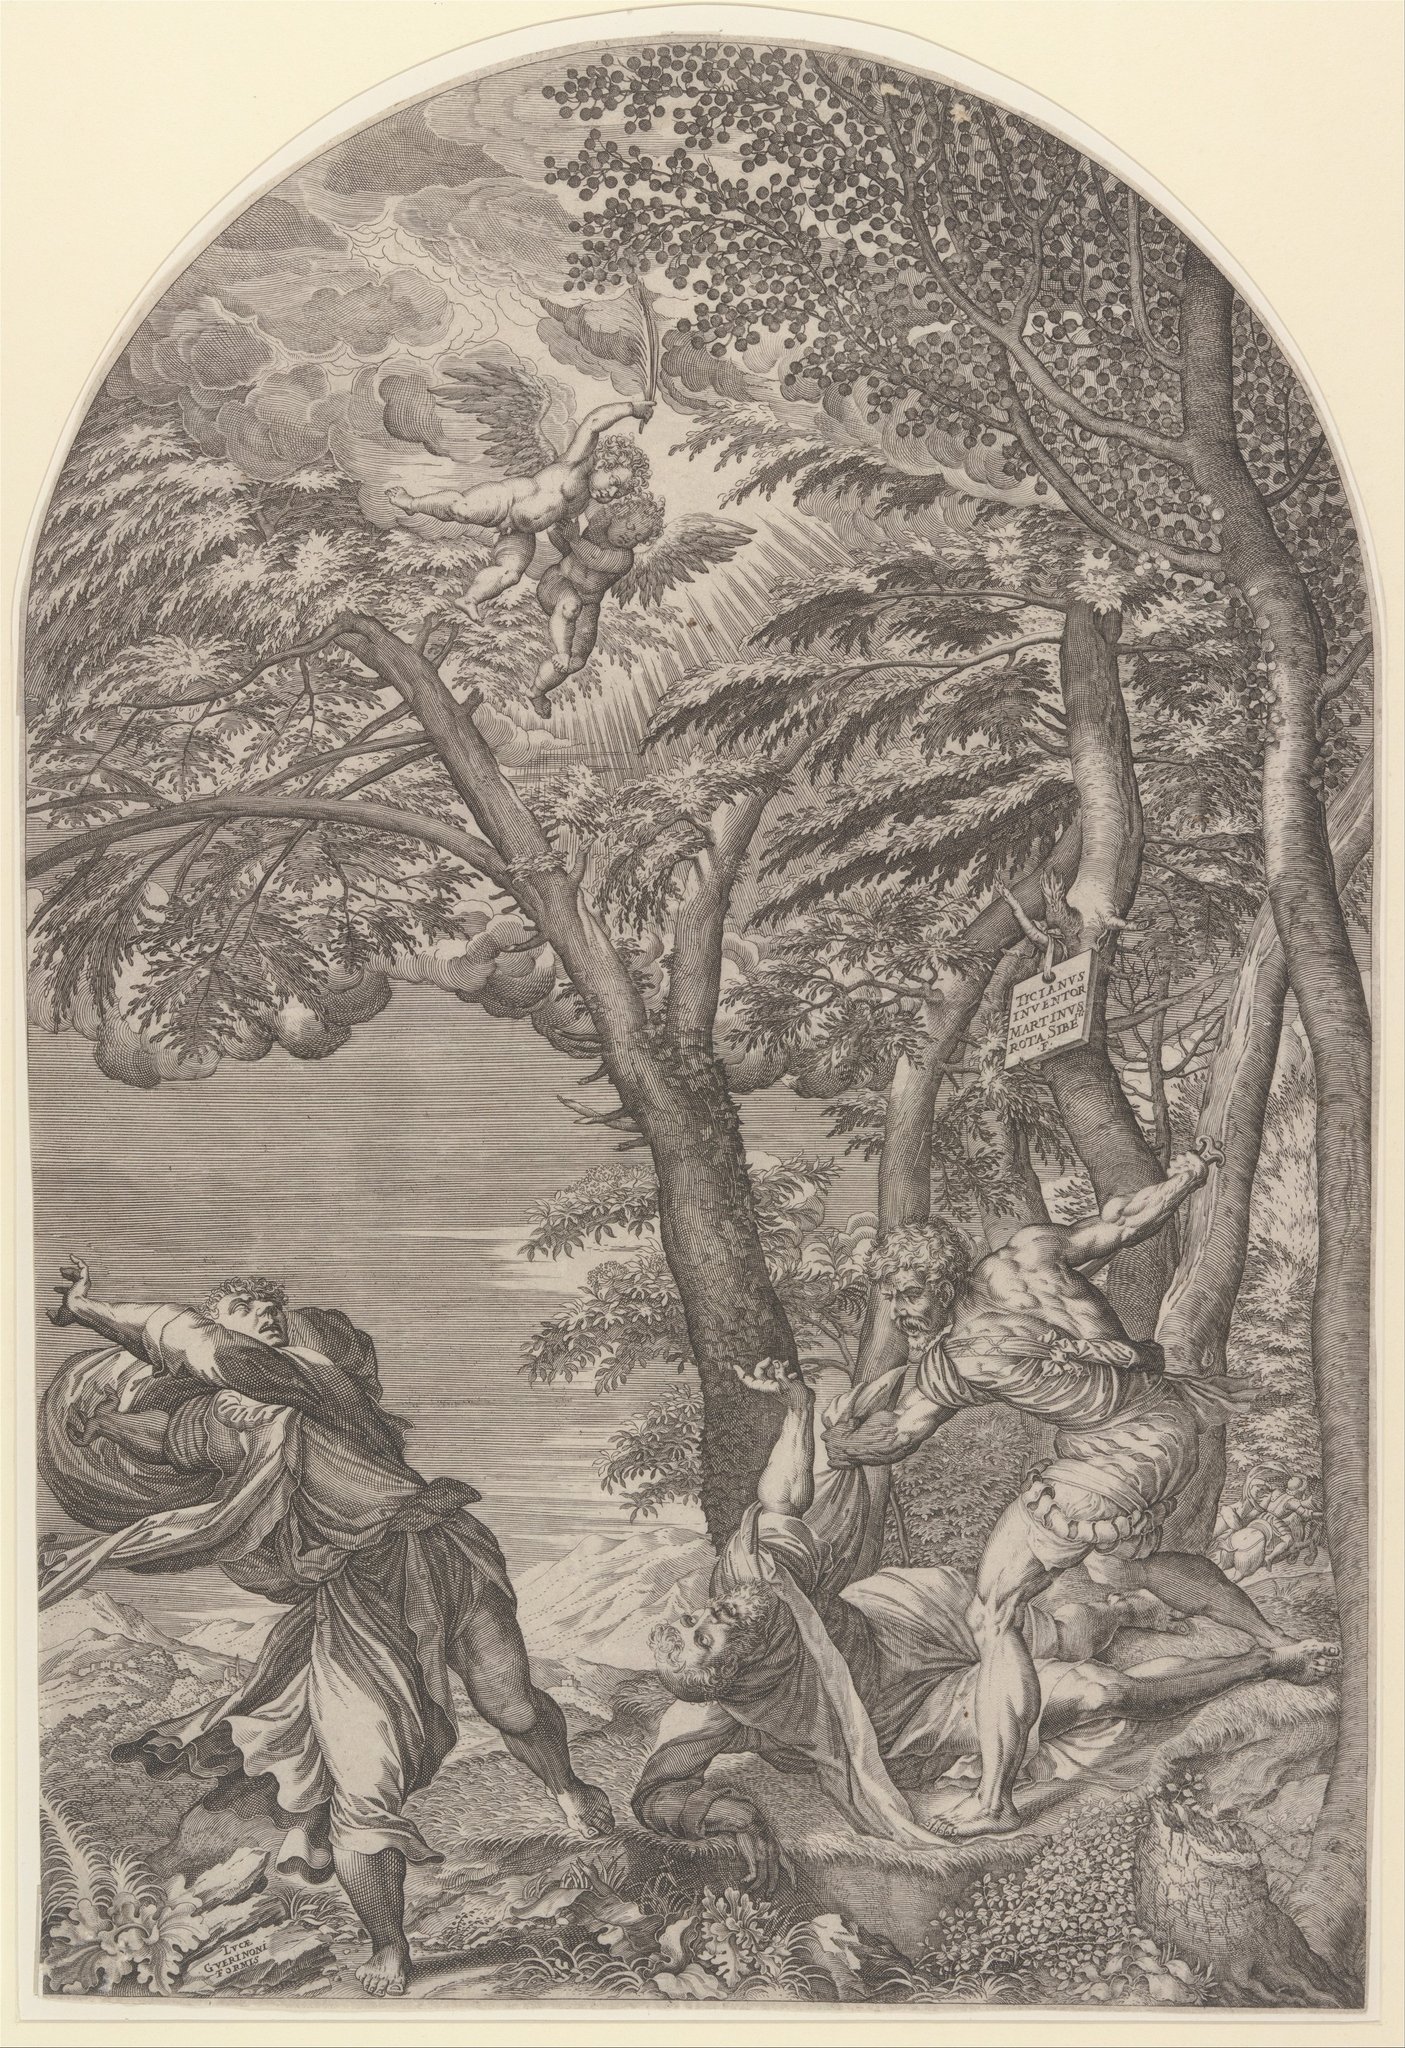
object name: print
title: The Martyrdom of Saint Peter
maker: martino rota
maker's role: artist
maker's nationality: italian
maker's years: 1520-1583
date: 1560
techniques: engraving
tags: men,trees,angels,saint peter